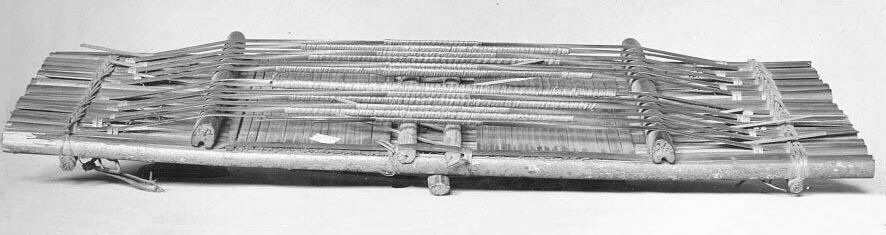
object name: zither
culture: beninese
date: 1867-1900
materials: bamboo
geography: benin